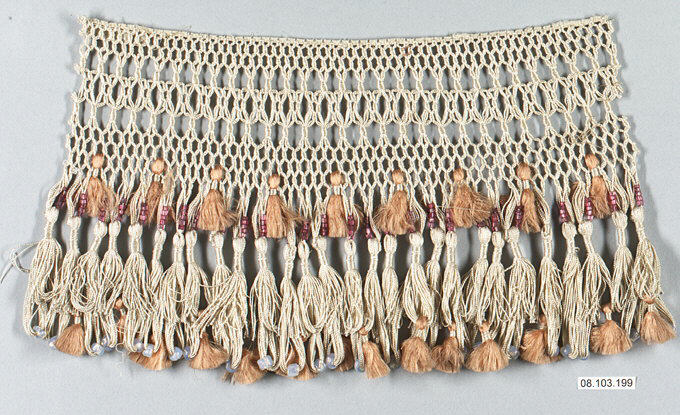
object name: fringe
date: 1801-1900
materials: silk